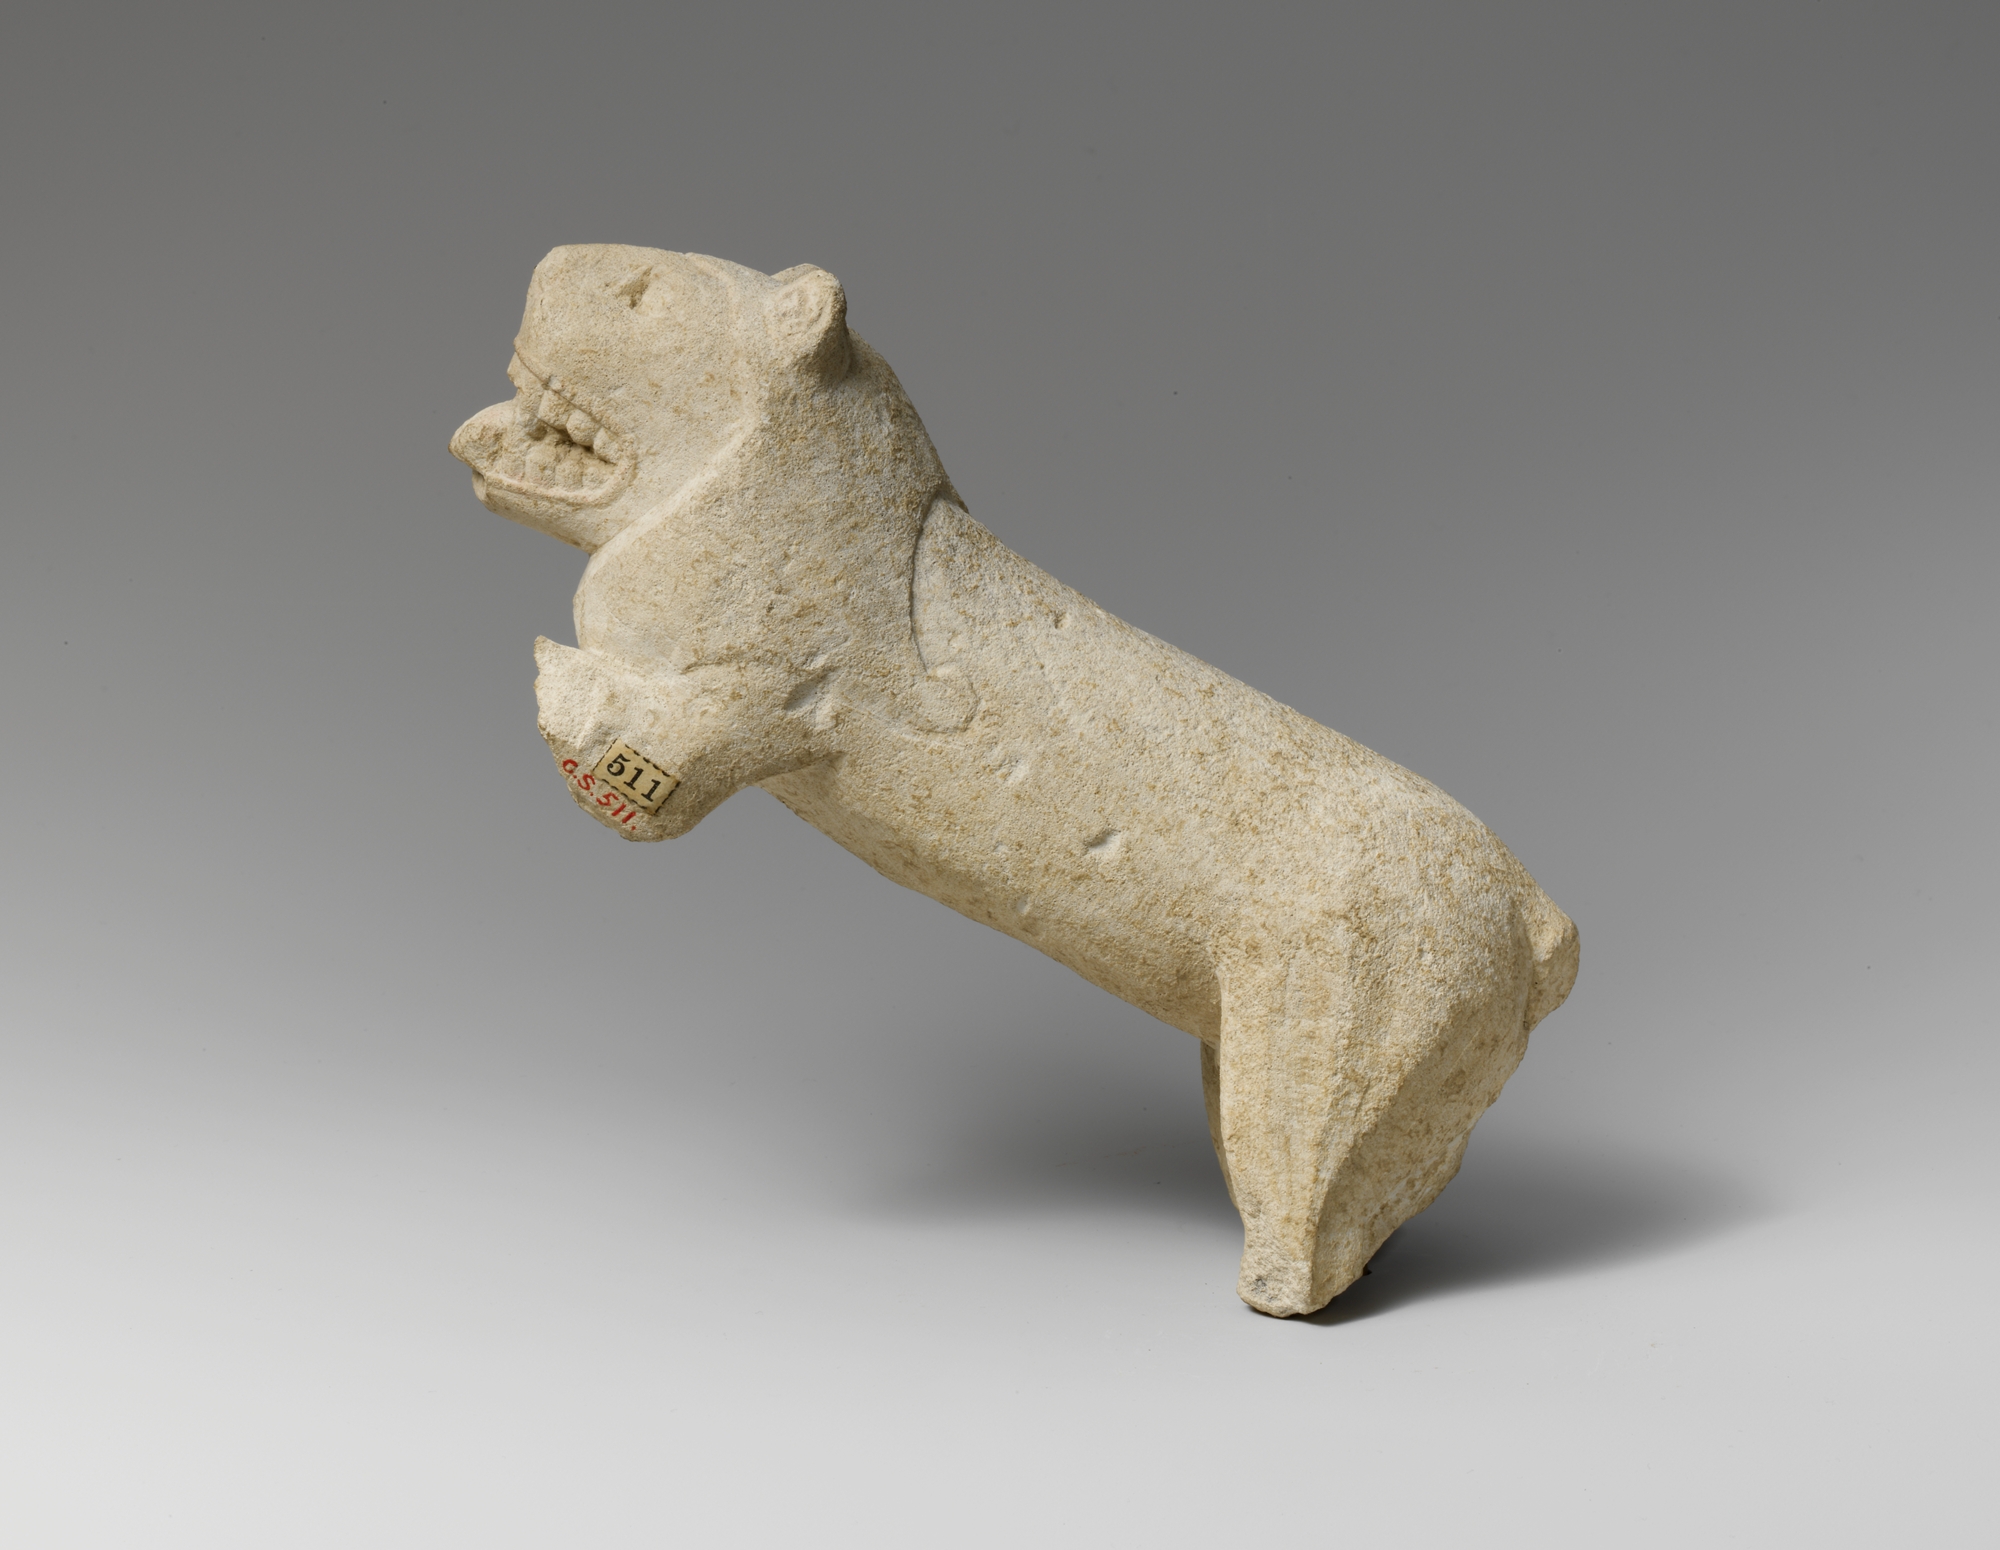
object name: statuette of a lion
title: Limestone statuette of a lion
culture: cypriot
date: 534-468 BCE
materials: limestone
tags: lions